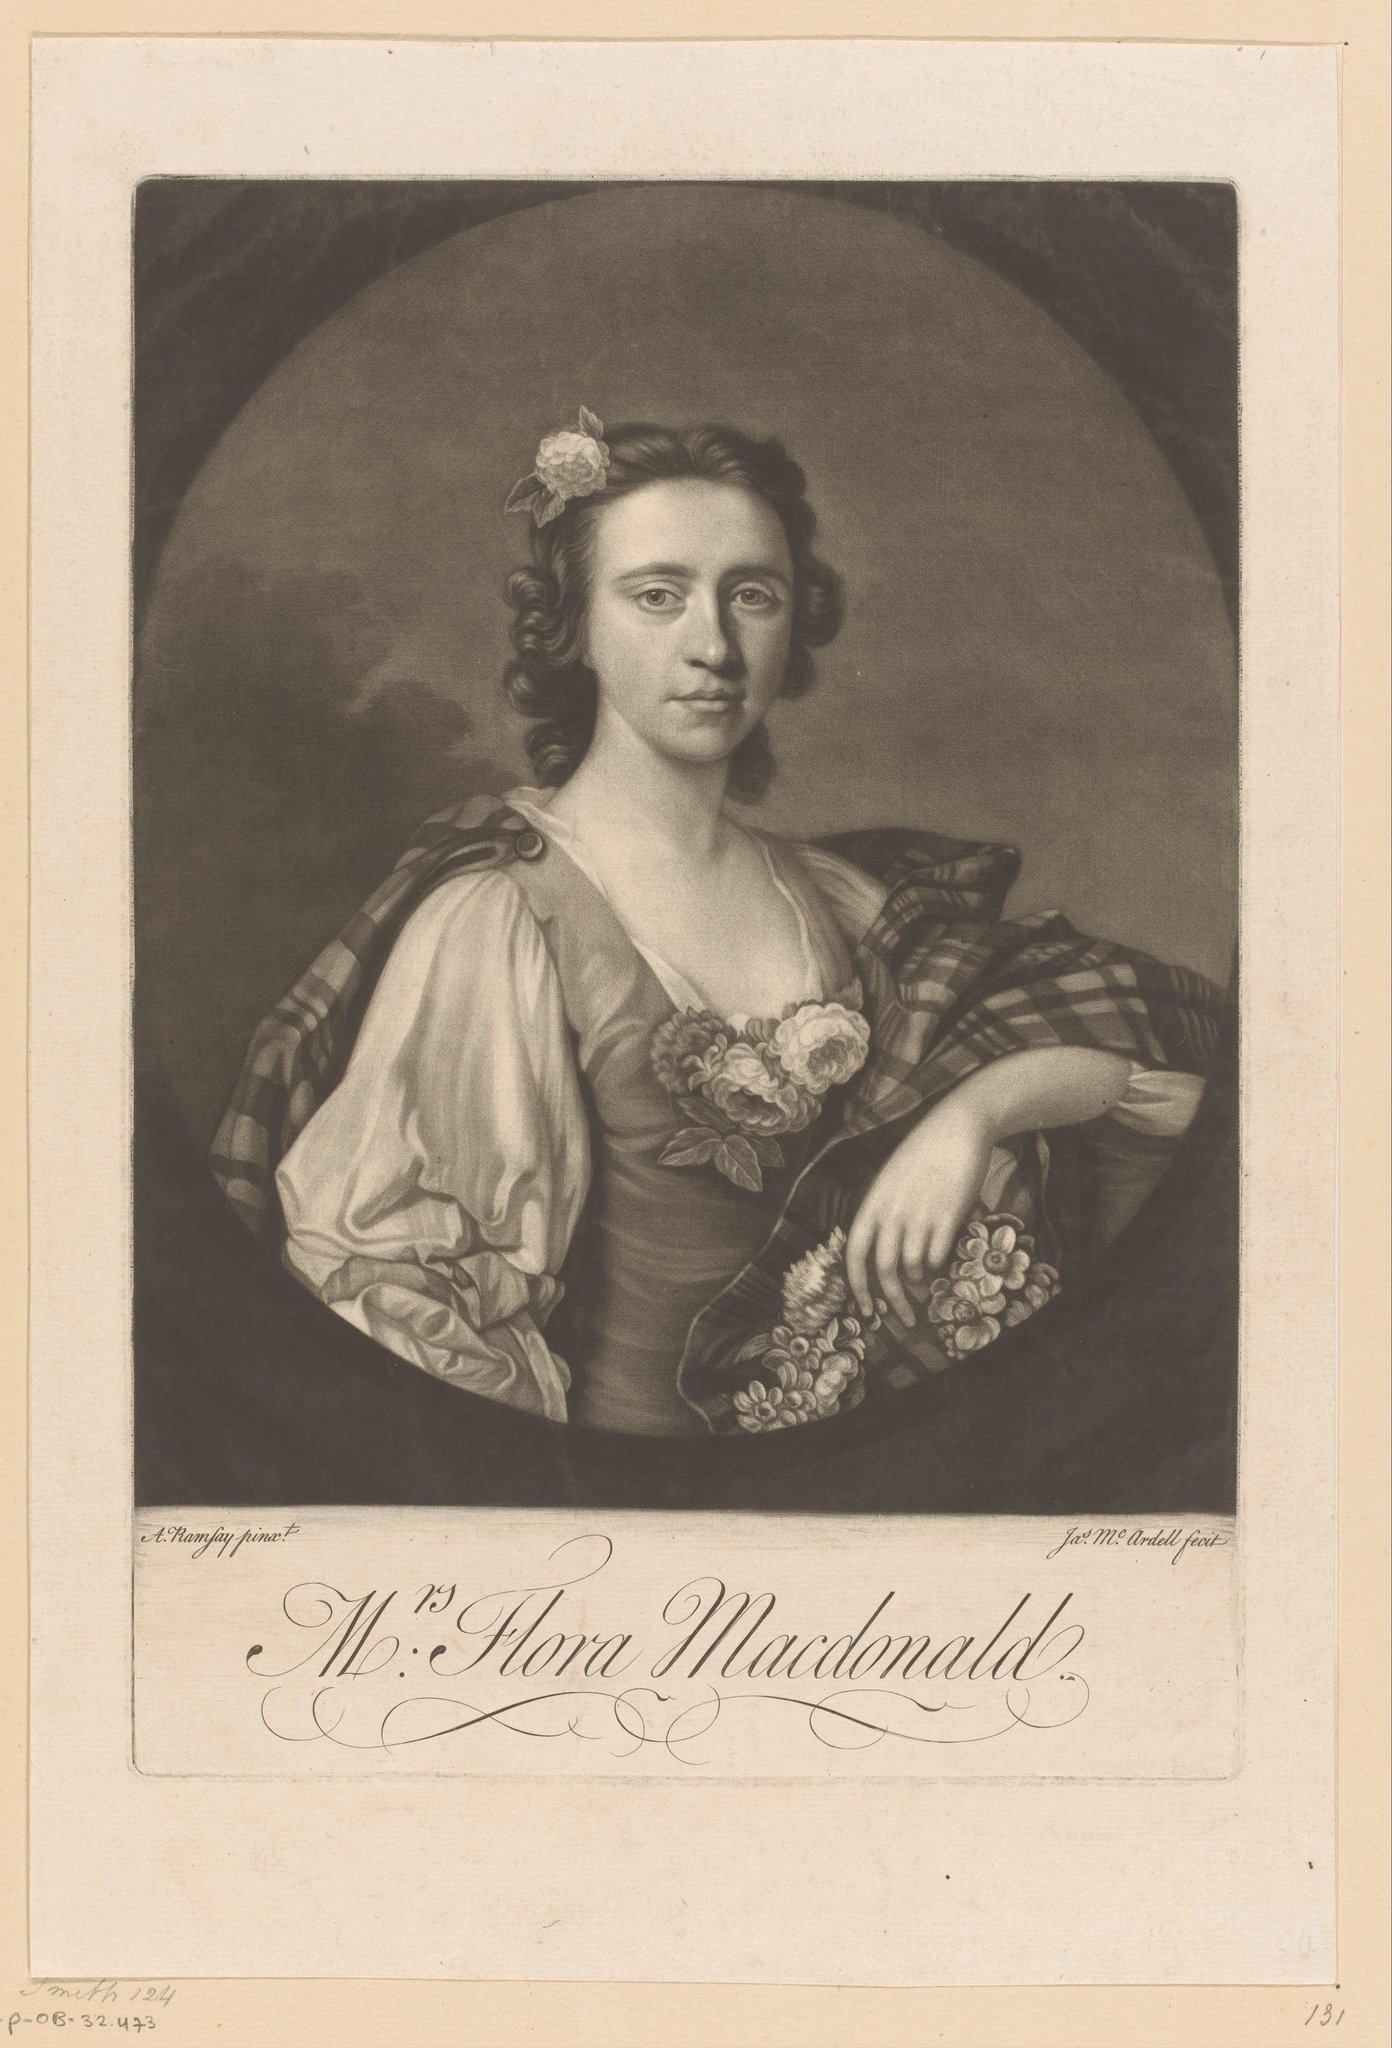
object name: print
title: Portret van Flora MacDonald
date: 1749-1765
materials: paper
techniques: mezzotint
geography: london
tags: historical persons - bb - woman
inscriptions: collector's mark: Lugt 240